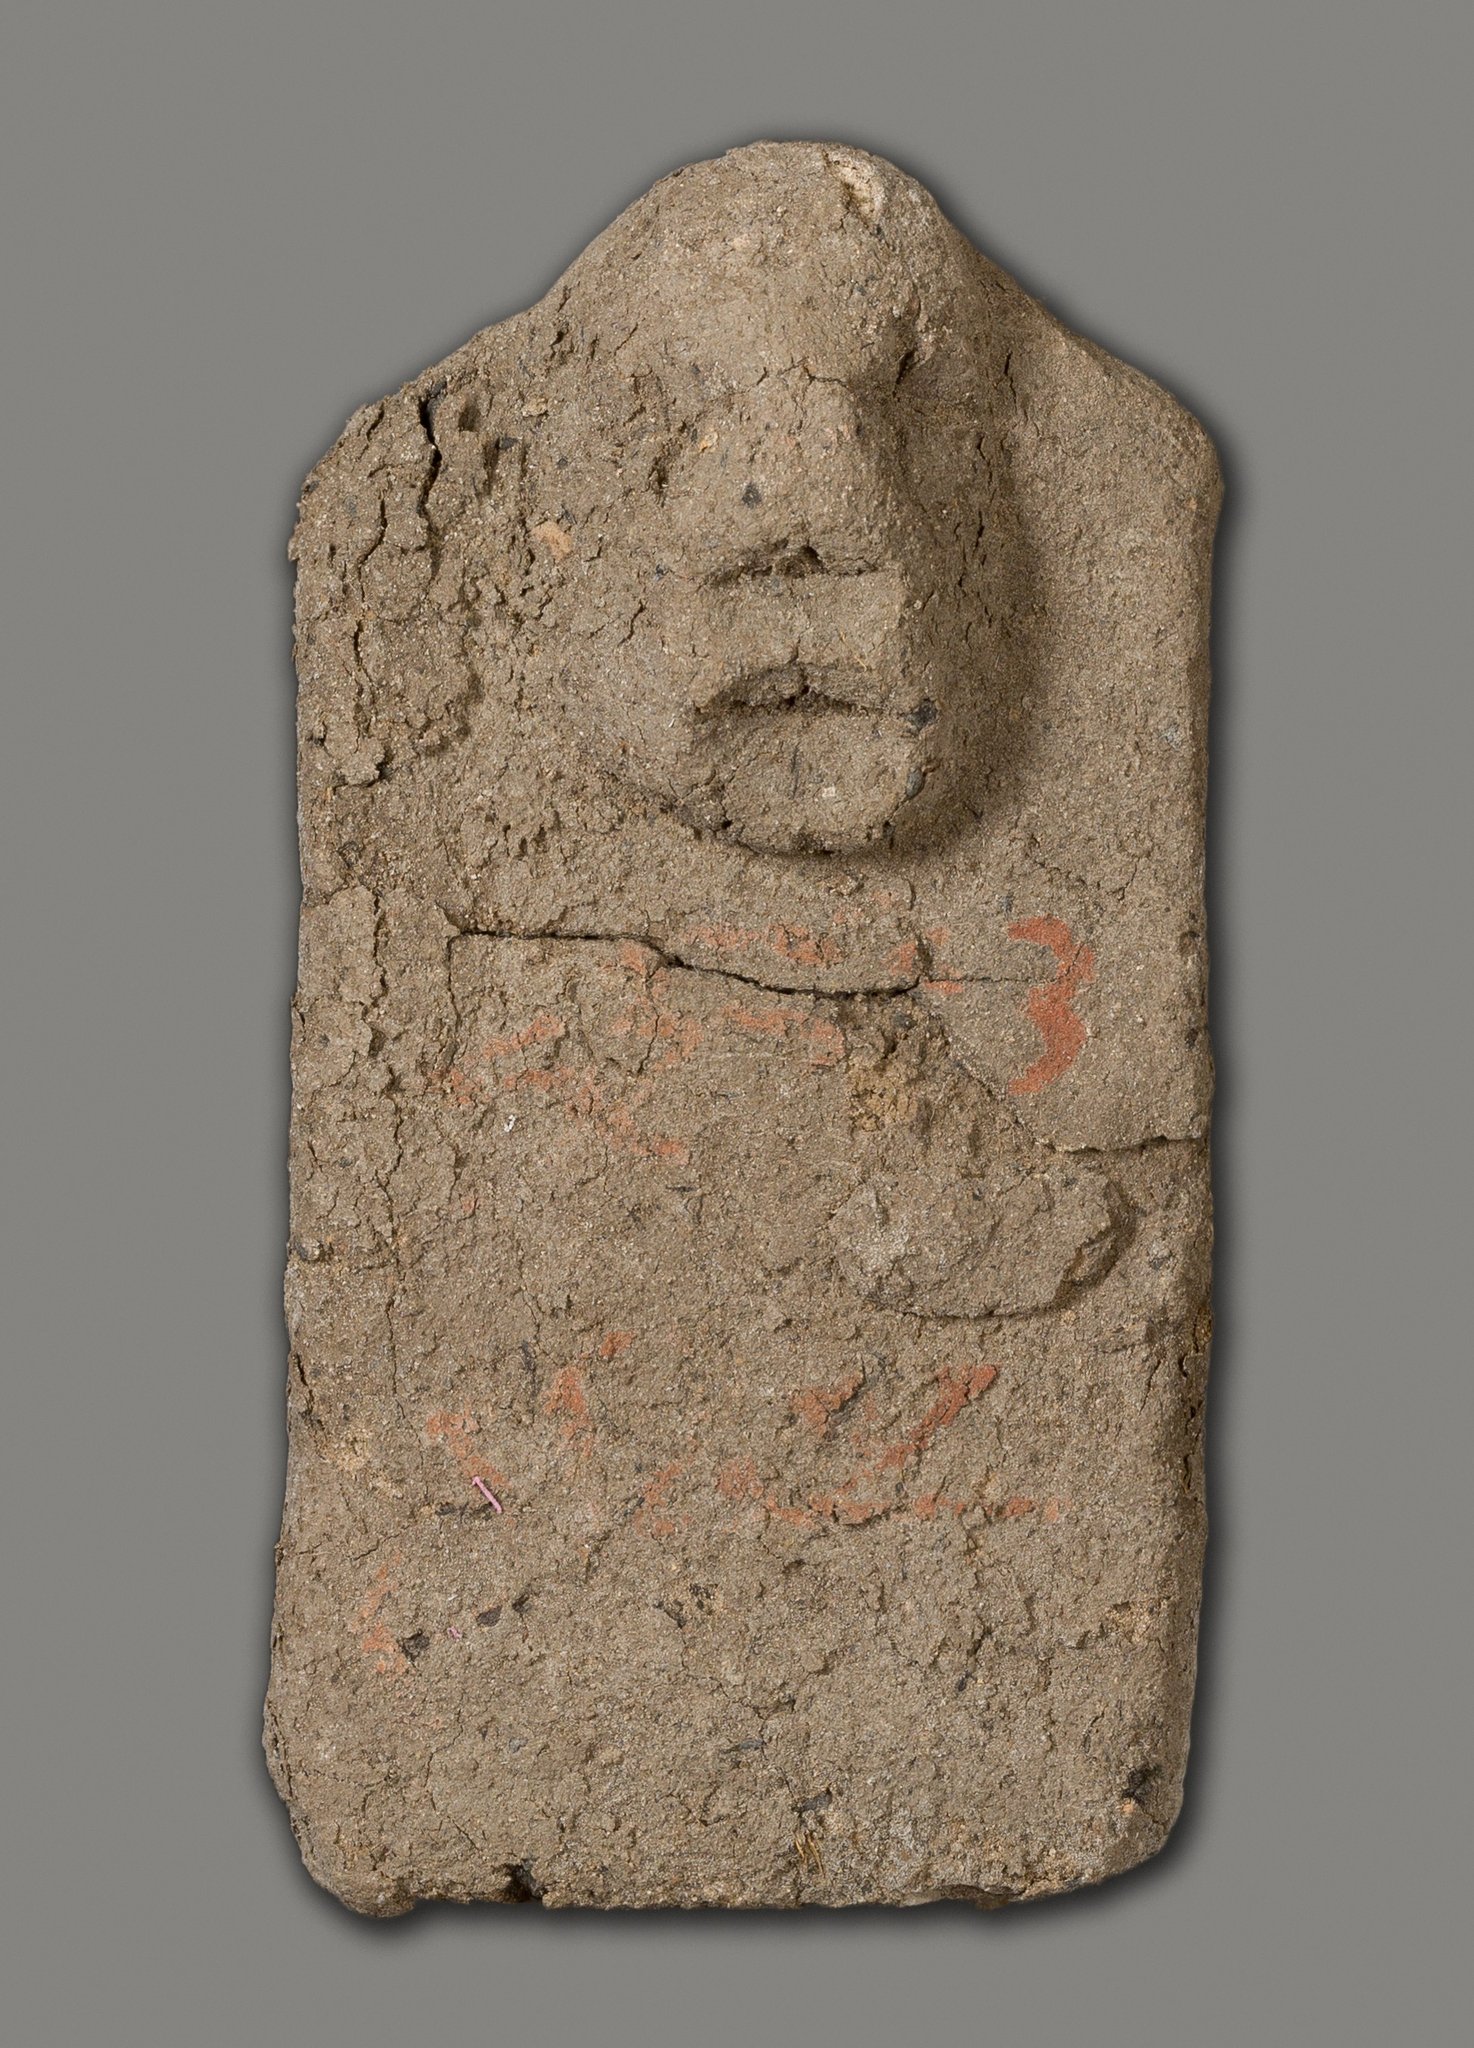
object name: figure, magical, execration, tablet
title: Magical Figure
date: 1802-1550 BCE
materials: clay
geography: egypt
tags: faces